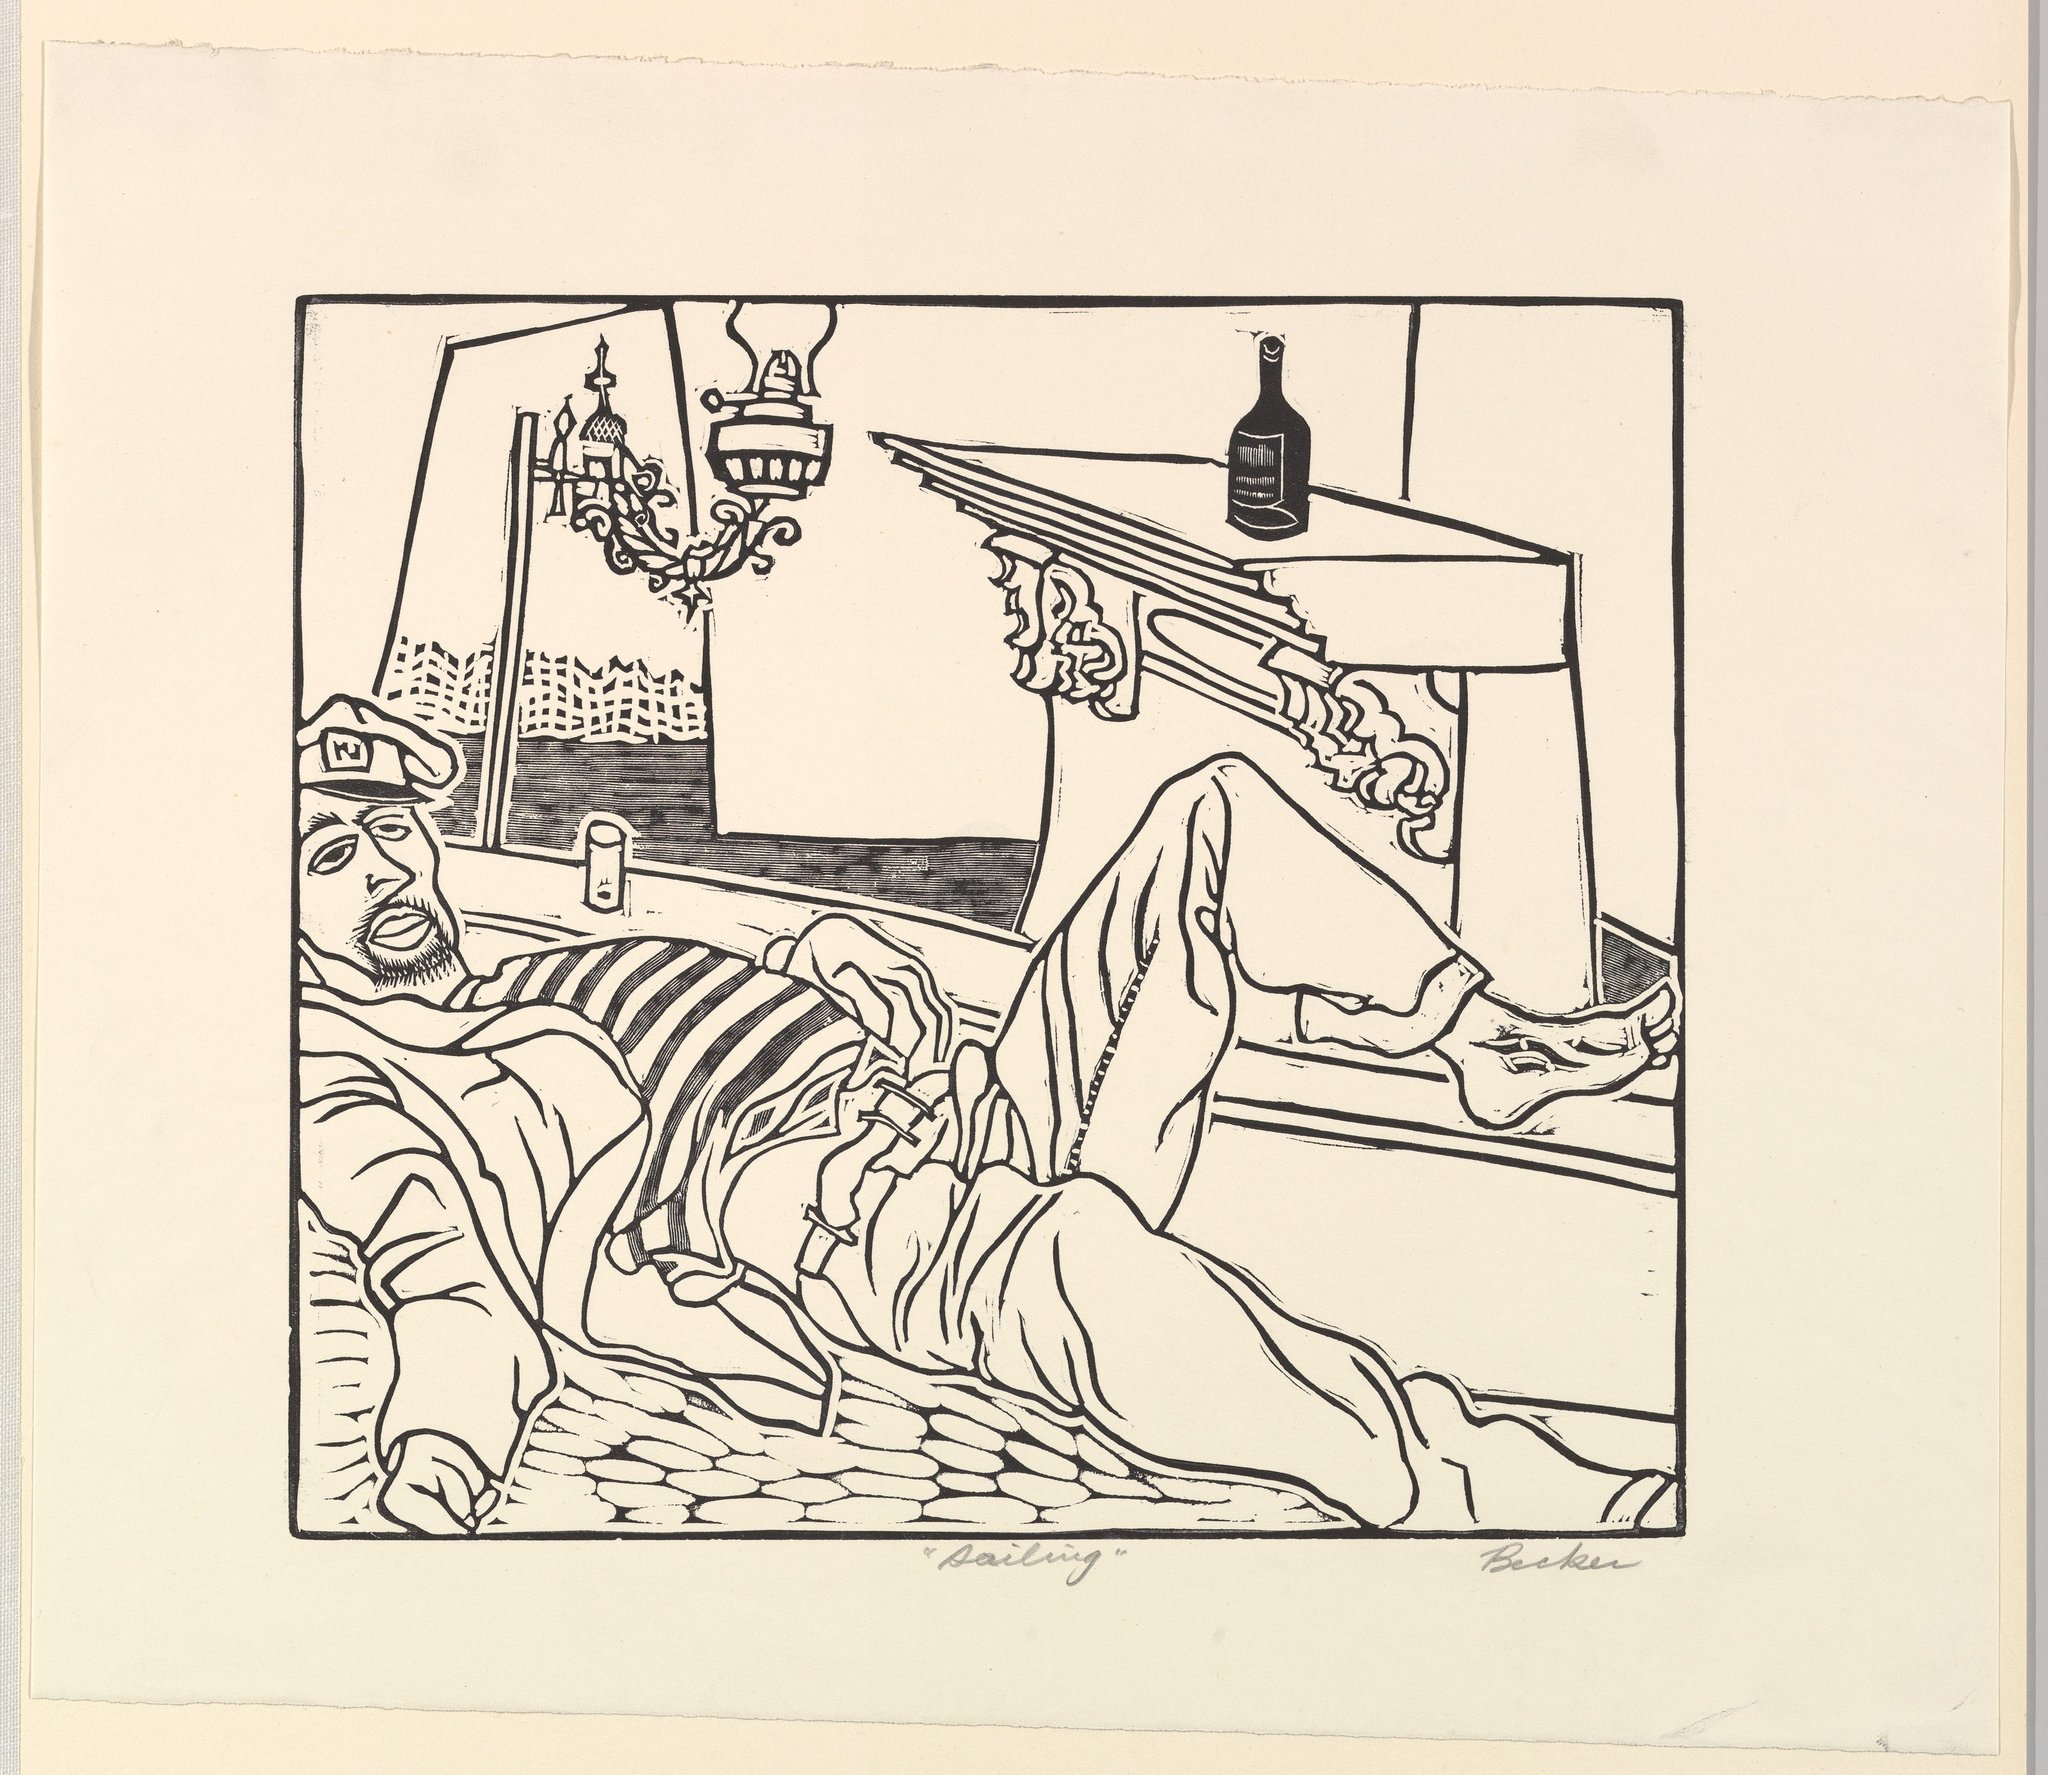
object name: print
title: Sailing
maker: fred becker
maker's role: artist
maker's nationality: american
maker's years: 1913-2004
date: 1935-1940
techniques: engraving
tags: men,sailing,bottles